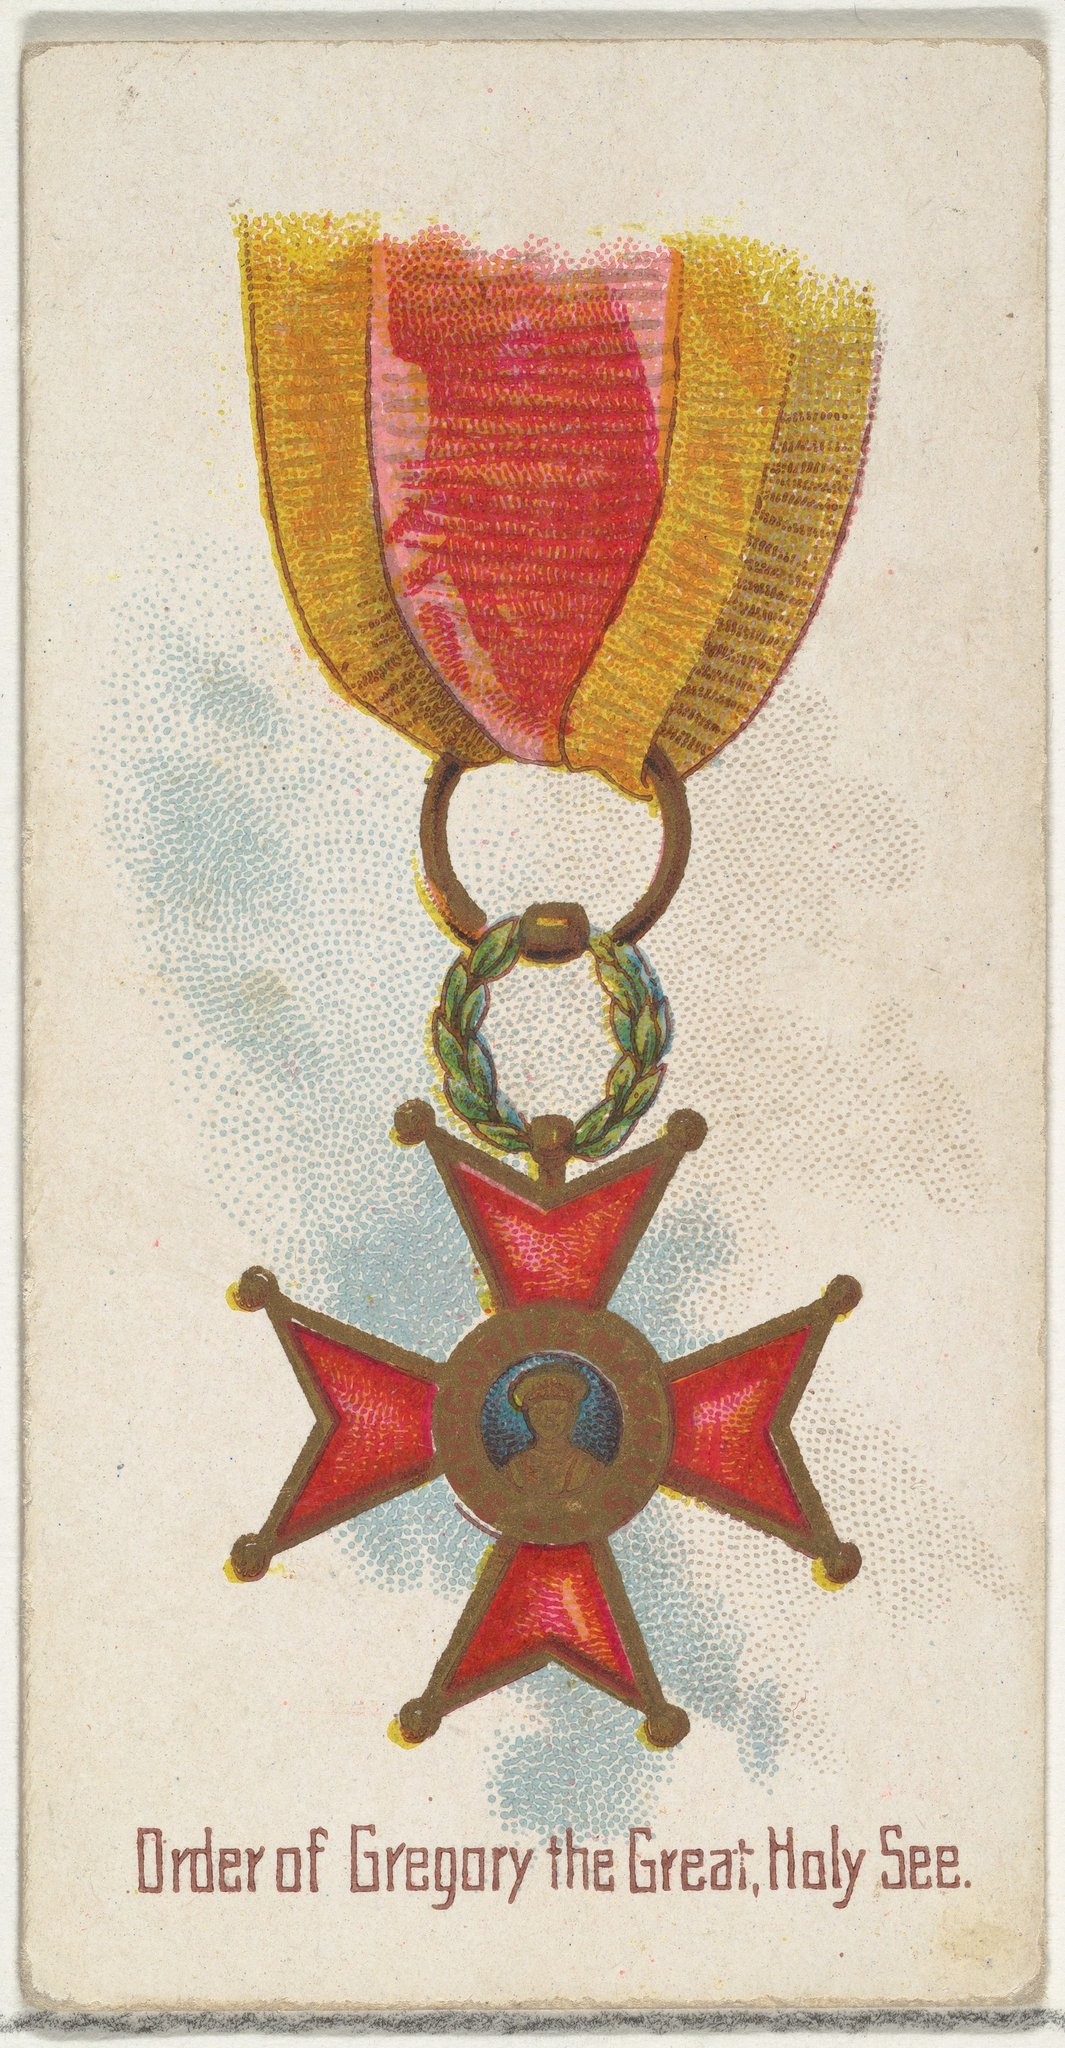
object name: print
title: Order of Gregory the Great, Holy See, from the World's Decorations series (N30) for Allen & Ginter Cigarettes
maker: allen & ginter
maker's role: publisher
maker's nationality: american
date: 1890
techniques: color lithograph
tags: medals